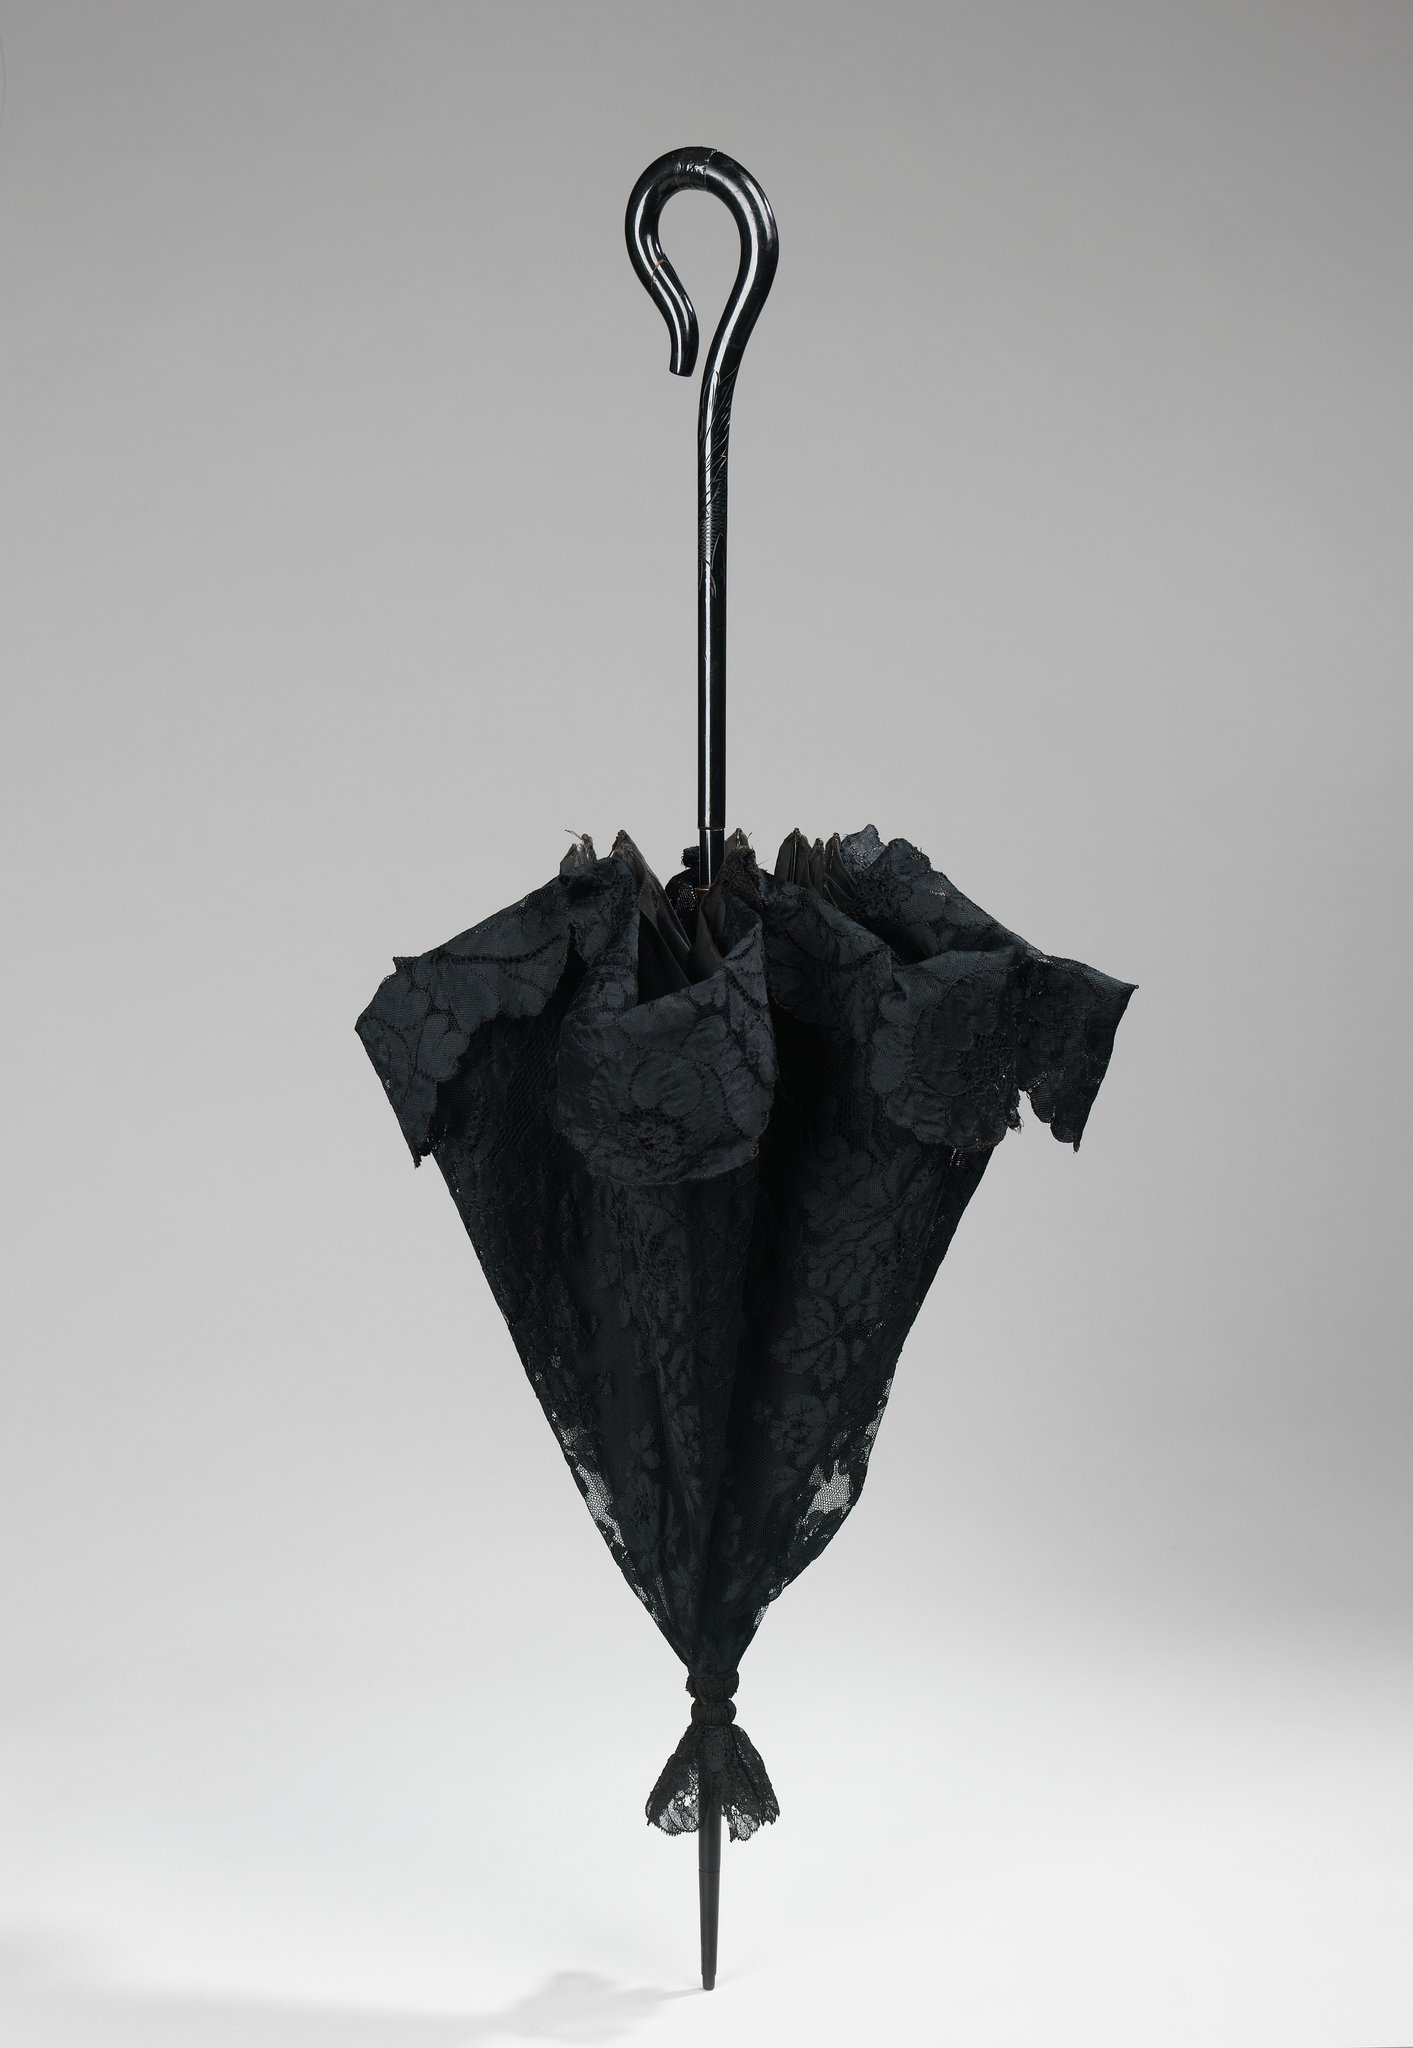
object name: parasol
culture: american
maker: follmer, clogg & company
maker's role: manufacturer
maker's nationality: american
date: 1880-1889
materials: metal, silk, wood